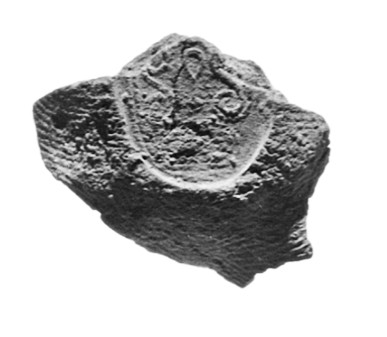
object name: sealing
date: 2030-1640 BCE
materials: clay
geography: egypt